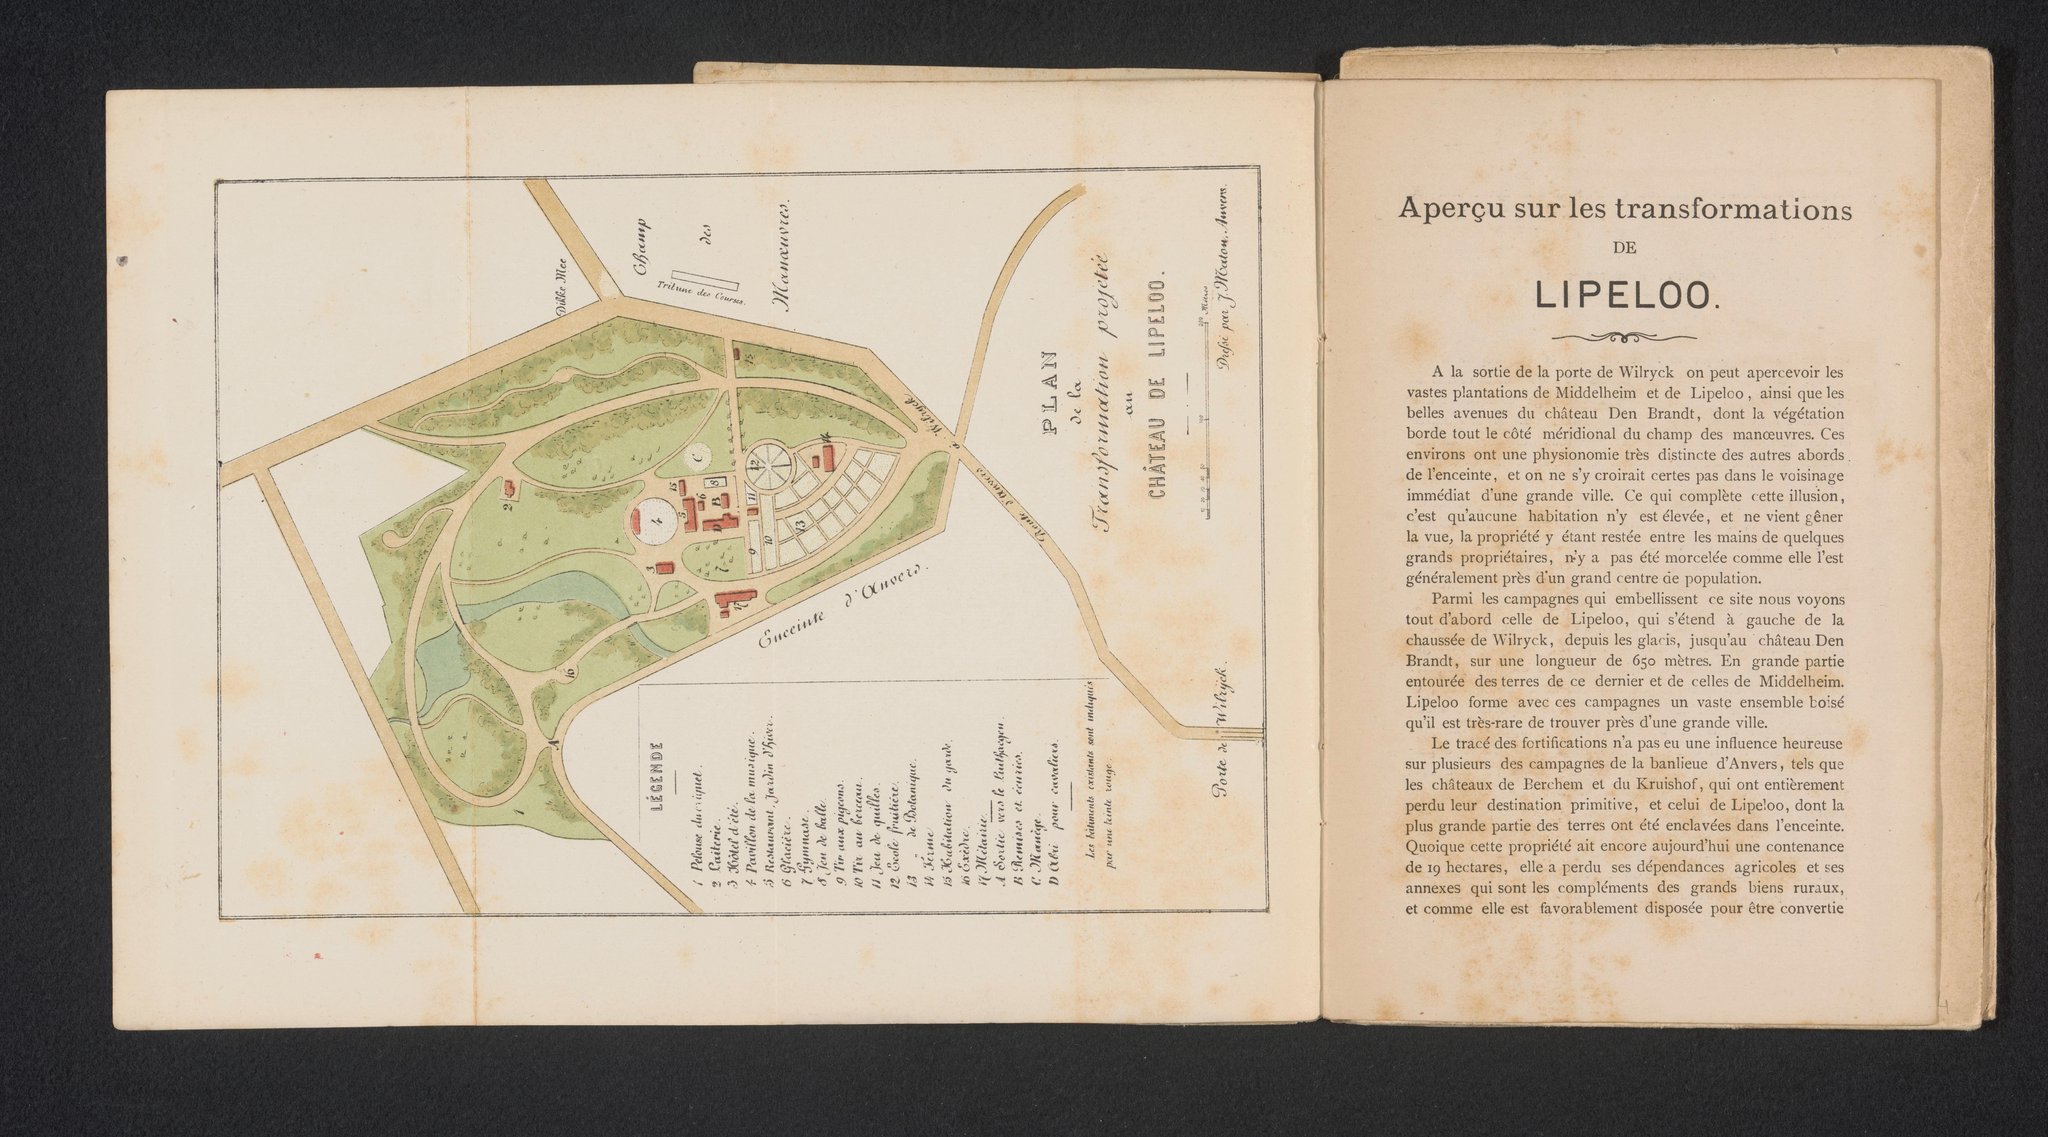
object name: photomechanical print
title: Plattegrond van de geplande transformatie van Kasteel Lippelo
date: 1877-1882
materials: paper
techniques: photolithography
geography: antwerp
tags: landscapes